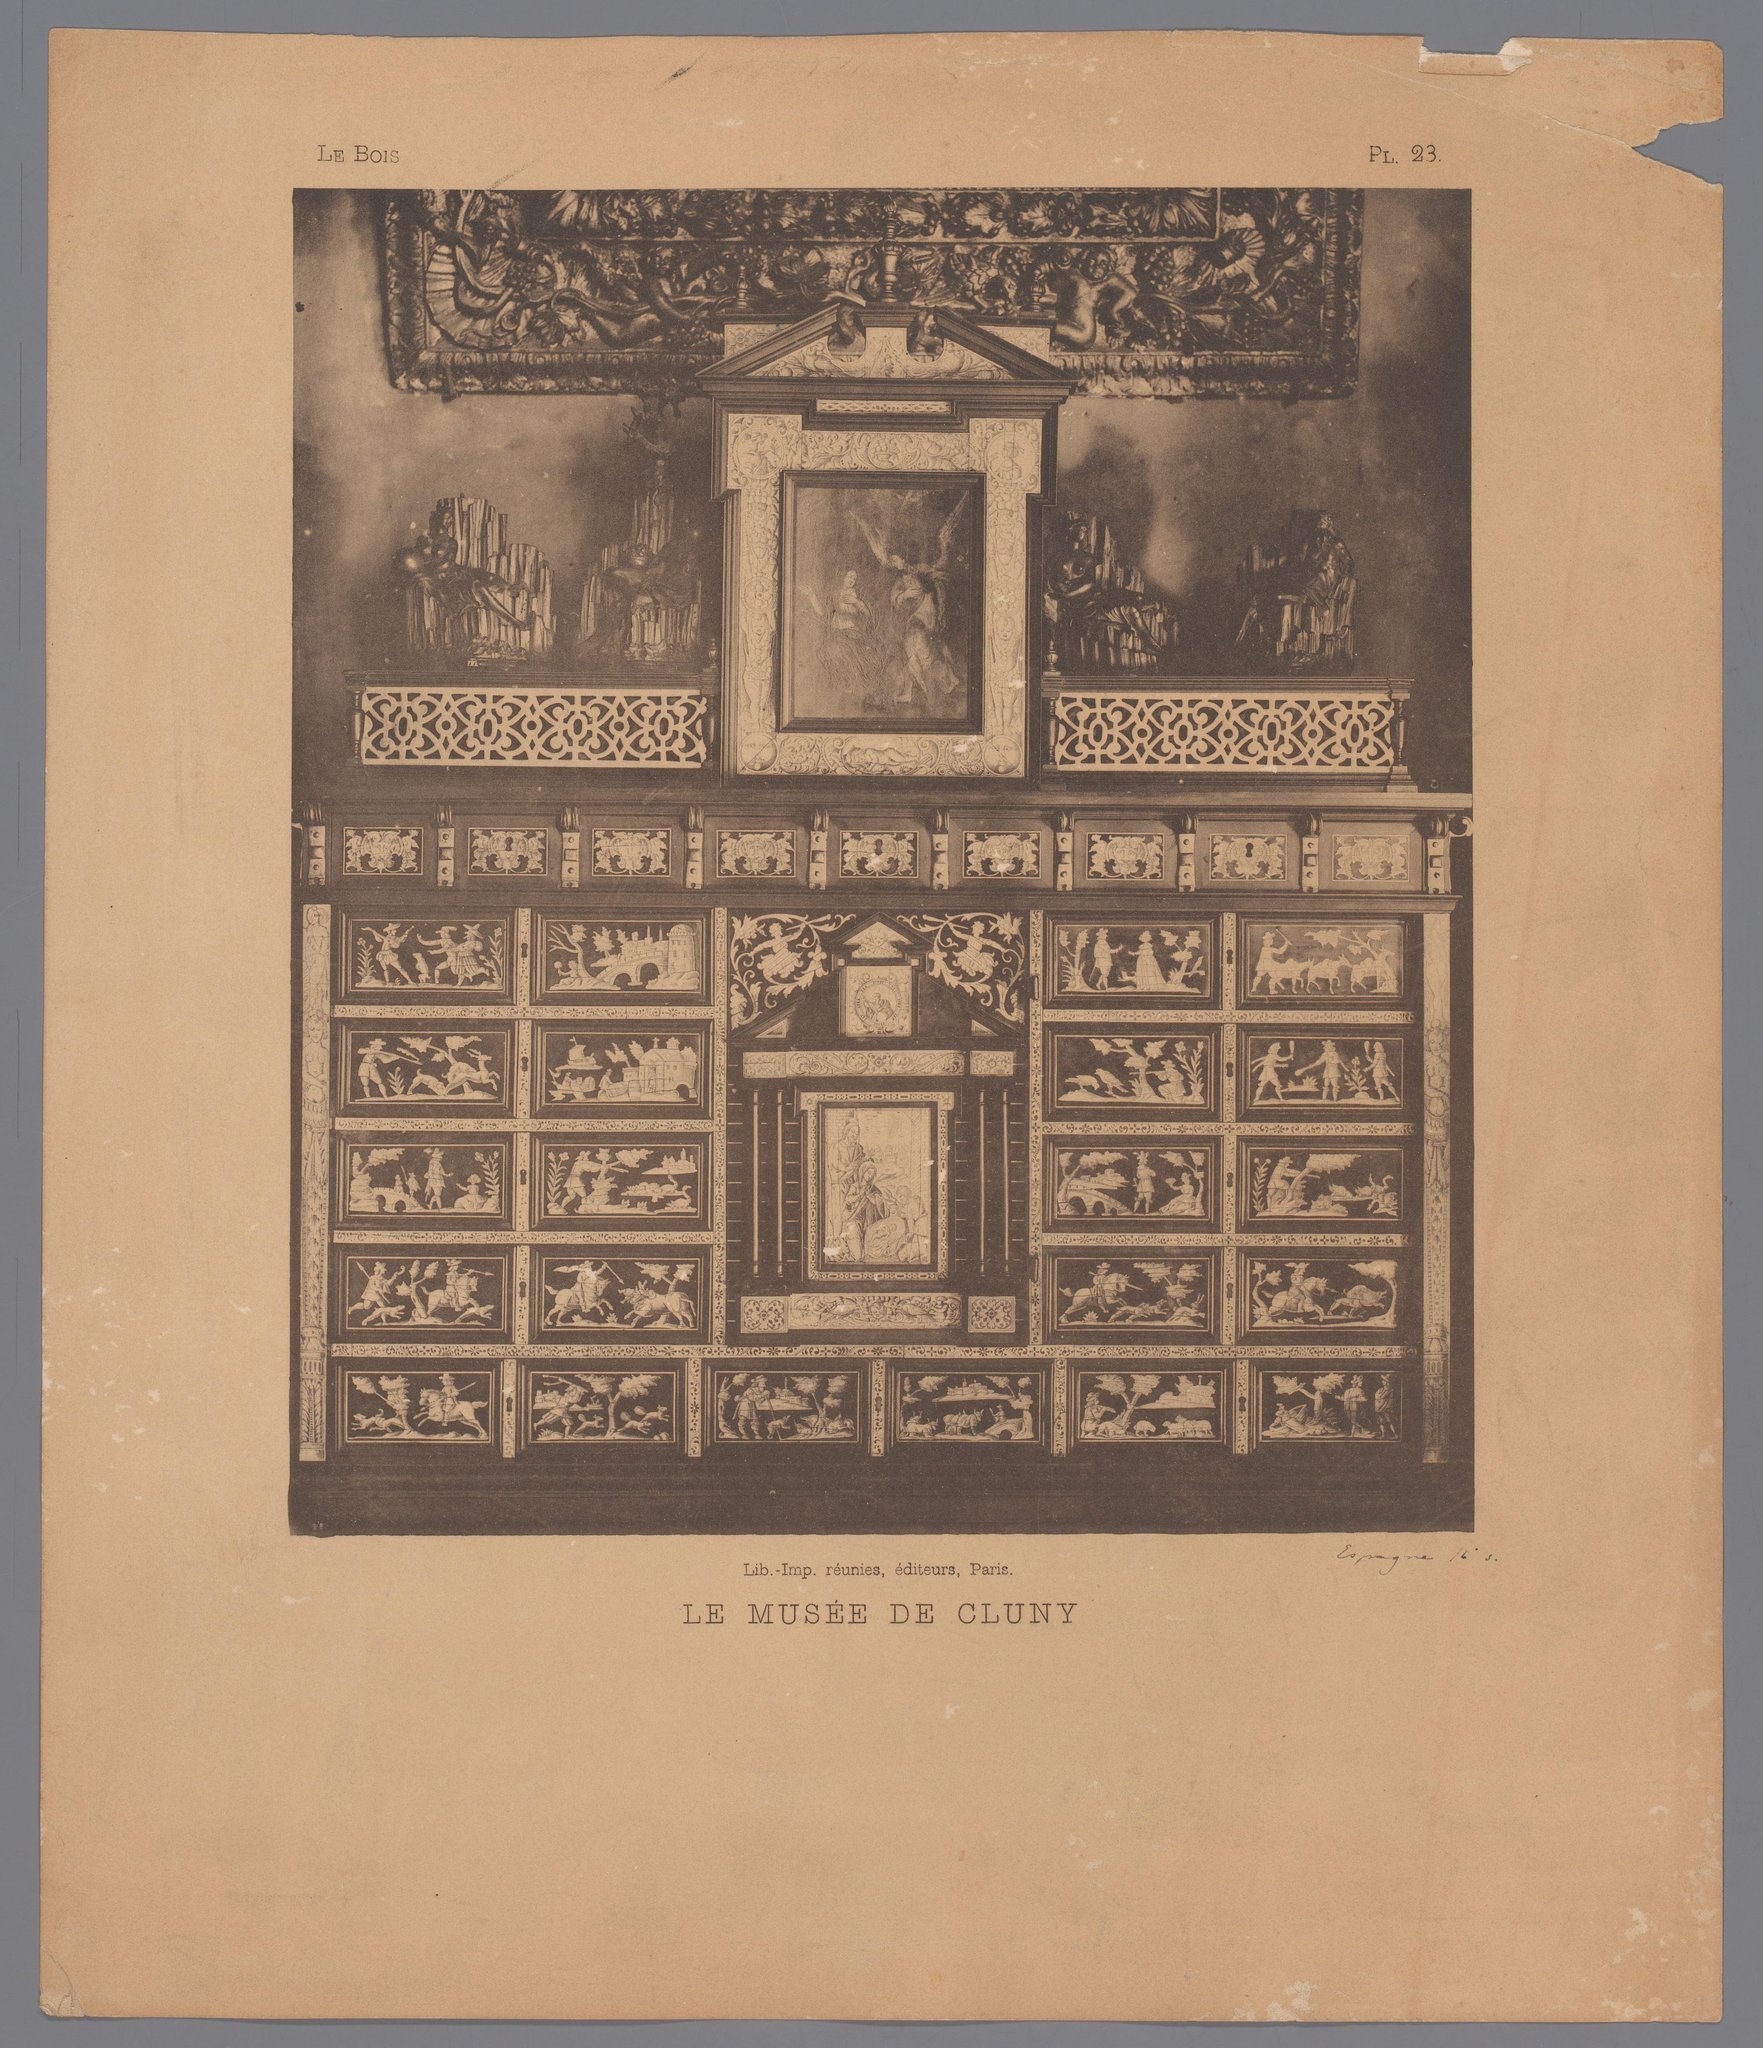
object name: photomechanical print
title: Gezicht op een kabinet met onder andere religieuze voorstellingen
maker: Anonymous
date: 1875-1930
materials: paper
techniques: photograph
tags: ornamental cupboard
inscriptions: inscription: ‘Espagne 16's.’, inscription: ‘Cabinet/ [...]’, inscription: ‘Le Bois Pl. 23.’, inscription: ‘Lib.-Imp. réunies, éditeurs, Paris./ Le Musée de Cluny’